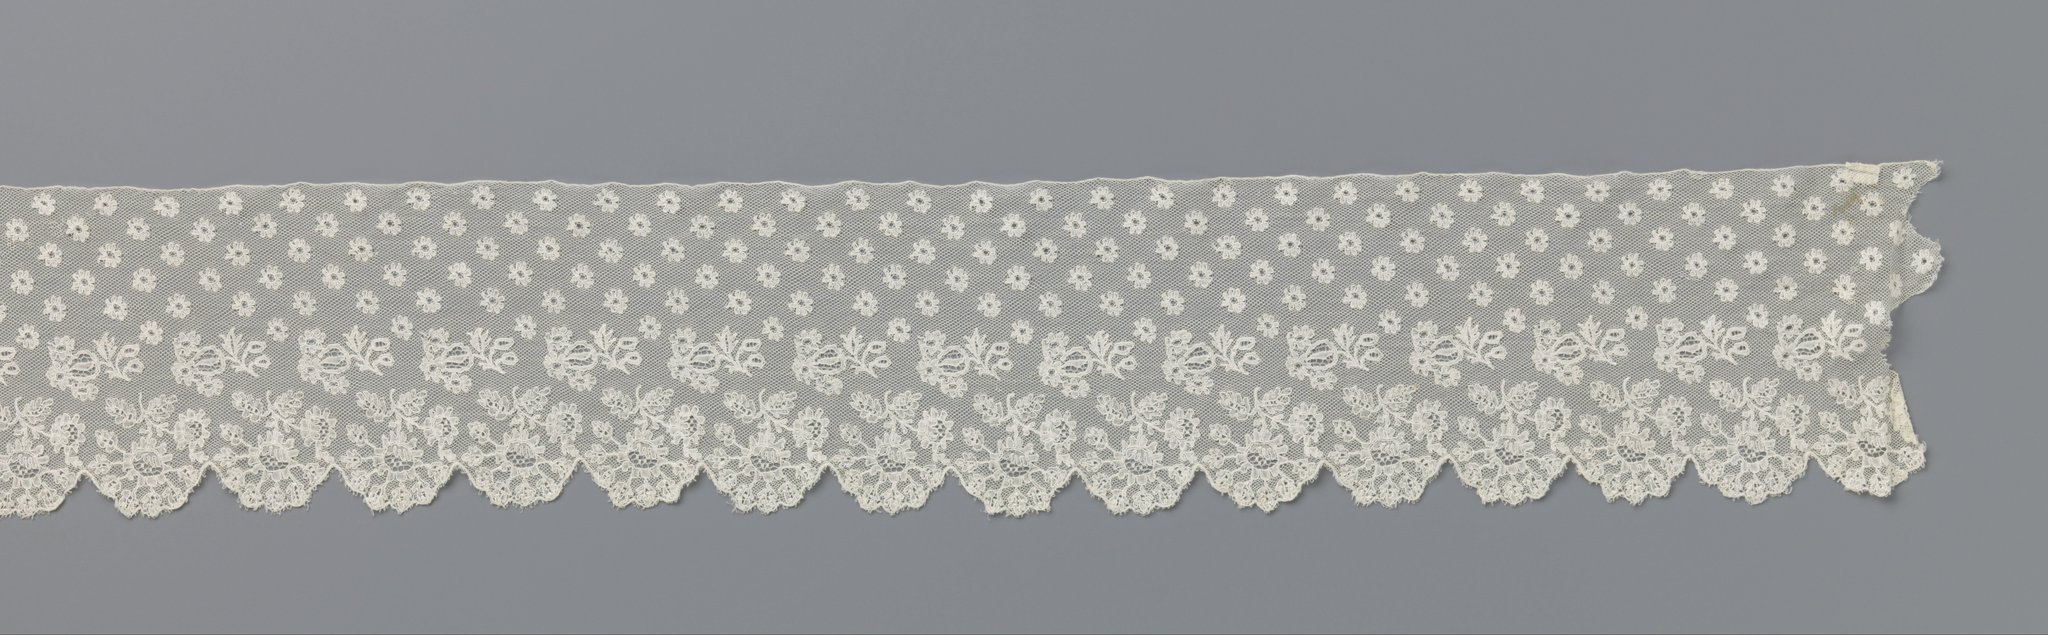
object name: strip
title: Strook kloskant met twee rijen bloempjes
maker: Anonymous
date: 1820-1830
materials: linen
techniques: lace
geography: southern netherlands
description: Strook naturelkleurig kloskant: Mechelse kant. Onder een strooipatroon van 'madeliefjes' staat een rij eenzijdig gerichte bloemtakjes en daar weer onder grotere, hangende bloemtakjes, die de schulpen vullen. De motieven zijn gemaakt in linnenslag en voorzien van dikkere en glimmende contourdraden. De motieven zijn met elkaar verbonden door een fijne traliegrond, een Mechelse grond. De schulpenrand is afgewerkt met picots. De bovenzijde van de strook is recht afgewerkt.